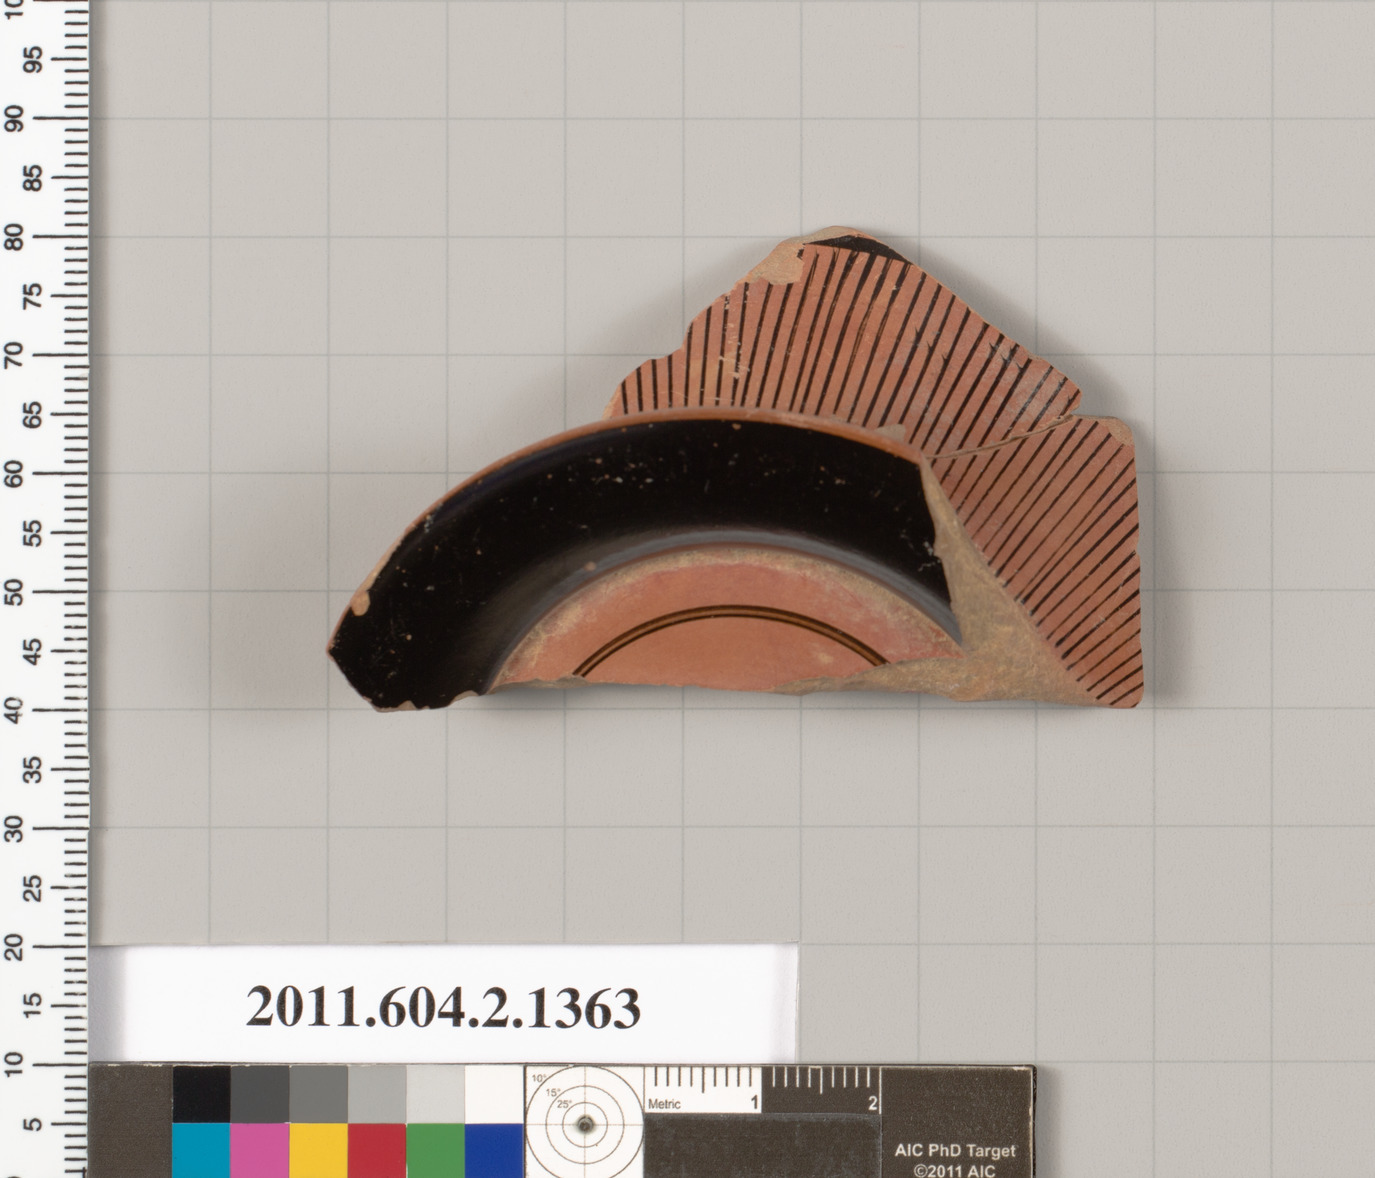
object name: skyphos fragment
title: Terracotta fragment of a skyphos (deep drinking cup)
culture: greek, attic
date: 470-460 BCE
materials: terracotta